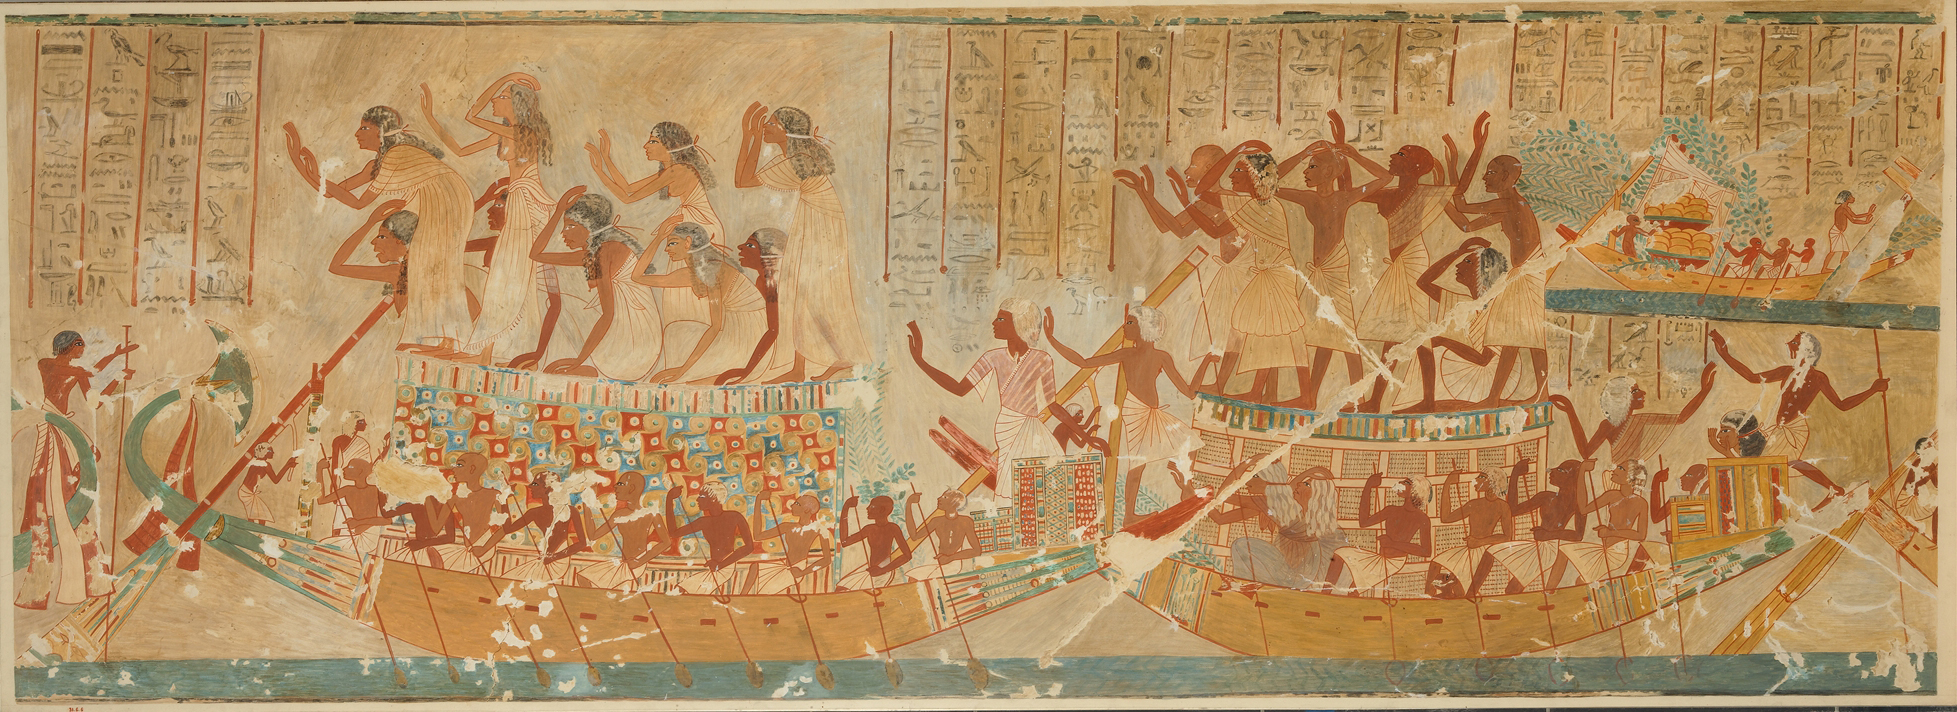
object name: facsimile, neferhotep tt 49, mourner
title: Boats with Mourners and Provisions, Tomb of Neferhotep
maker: nina de garis davies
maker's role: artist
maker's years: 1881-1965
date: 1327-1323 BCE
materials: paper, paint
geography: egypt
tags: men,women,hieroglyphs,boats